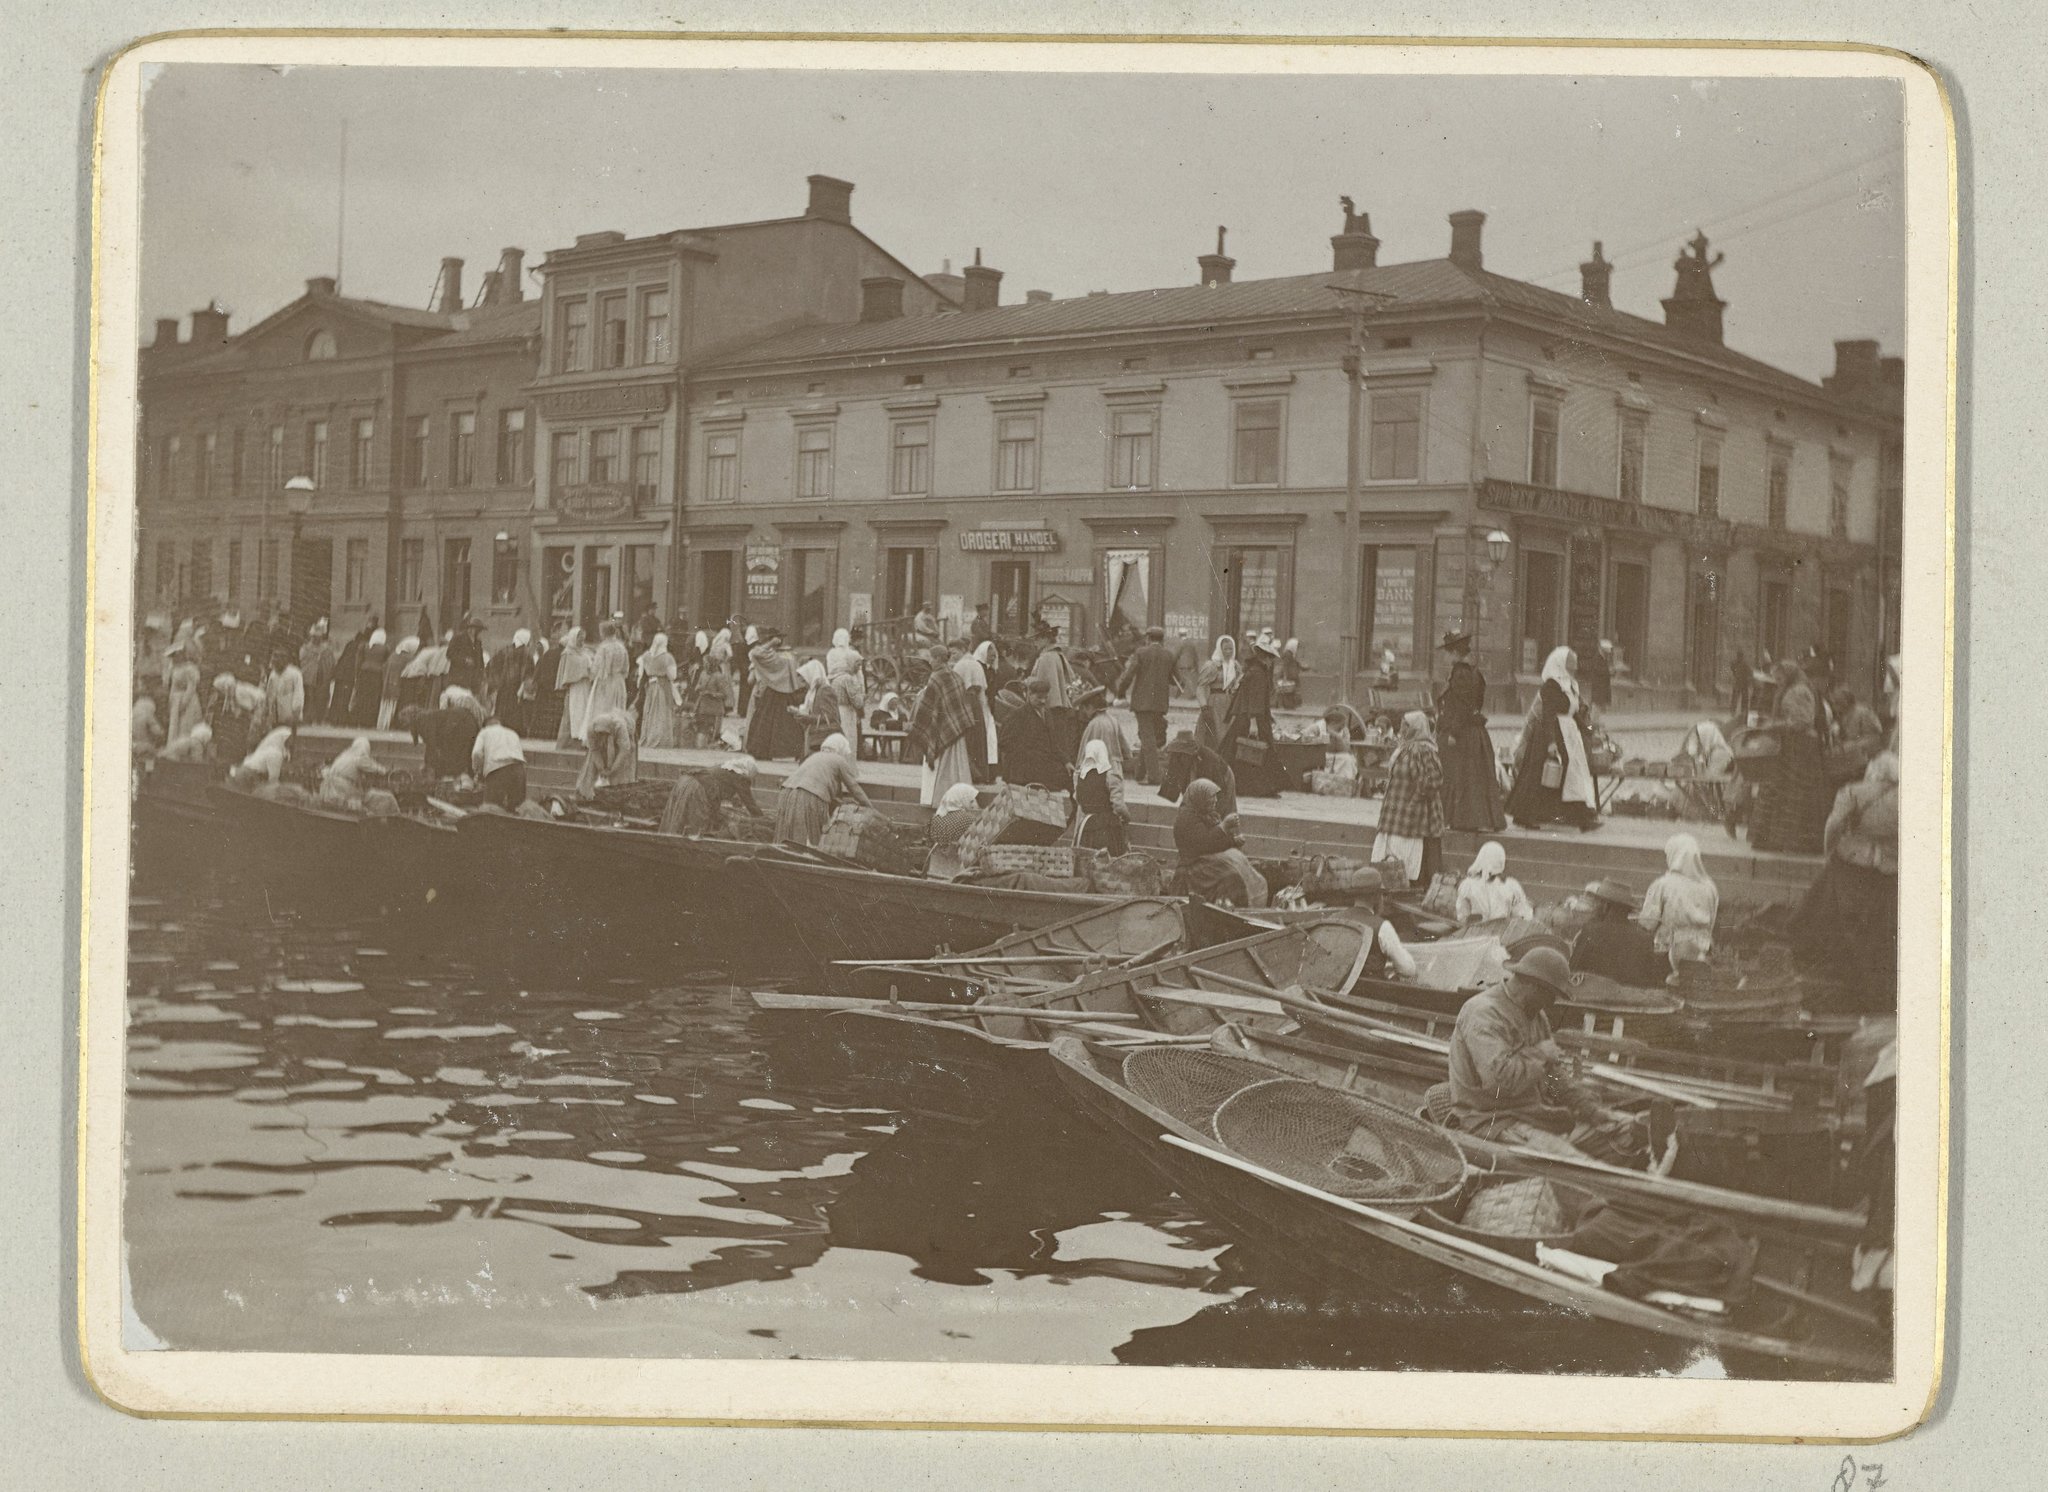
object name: photograph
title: Helsingfors Finland, Vischmarkt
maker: henry pauw van wieldrecht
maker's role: fotograaf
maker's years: 1863-1912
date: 1898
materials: paper, photographic support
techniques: albumen print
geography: netherlands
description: De markt Vene Satama in Helsinki met aangemeerde bootjes met handel op de druk bezochte kade.